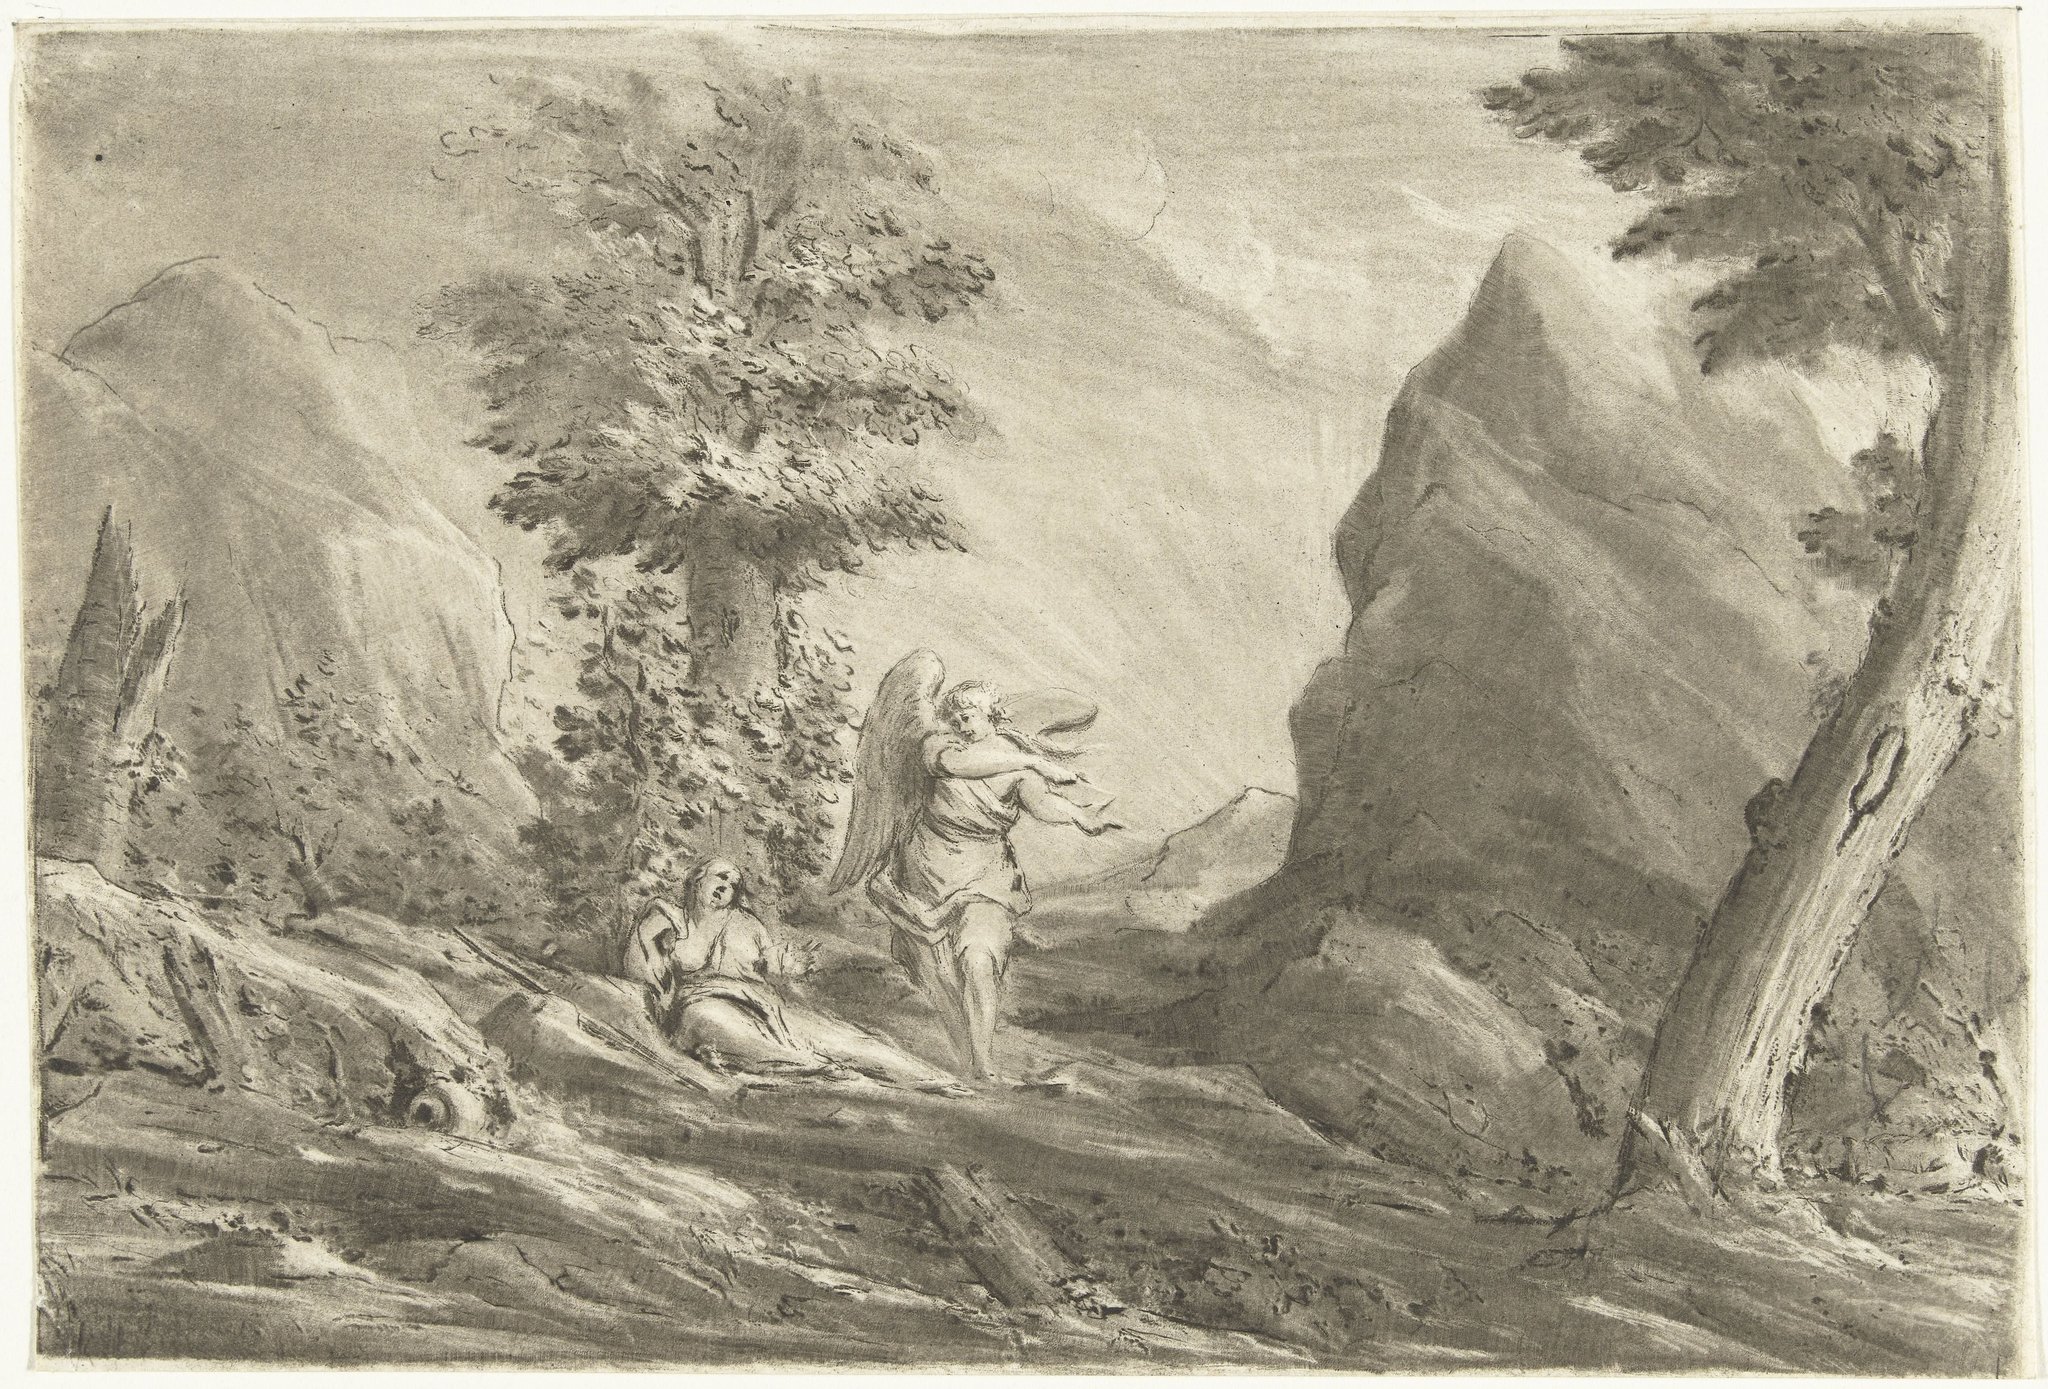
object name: print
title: Hagar in de woestijn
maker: jurriaan cootwijck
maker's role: print maker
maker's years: 1714-1798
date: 1759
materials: paper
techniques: print drawing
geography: amsterdam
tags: an angel appears and reveals a well of water to hagar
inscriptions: collector's mark: Lugt 2228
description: Hagar ligt op de grond in een bergachtig landschap. Een engel wijst haar naar een waterbron.